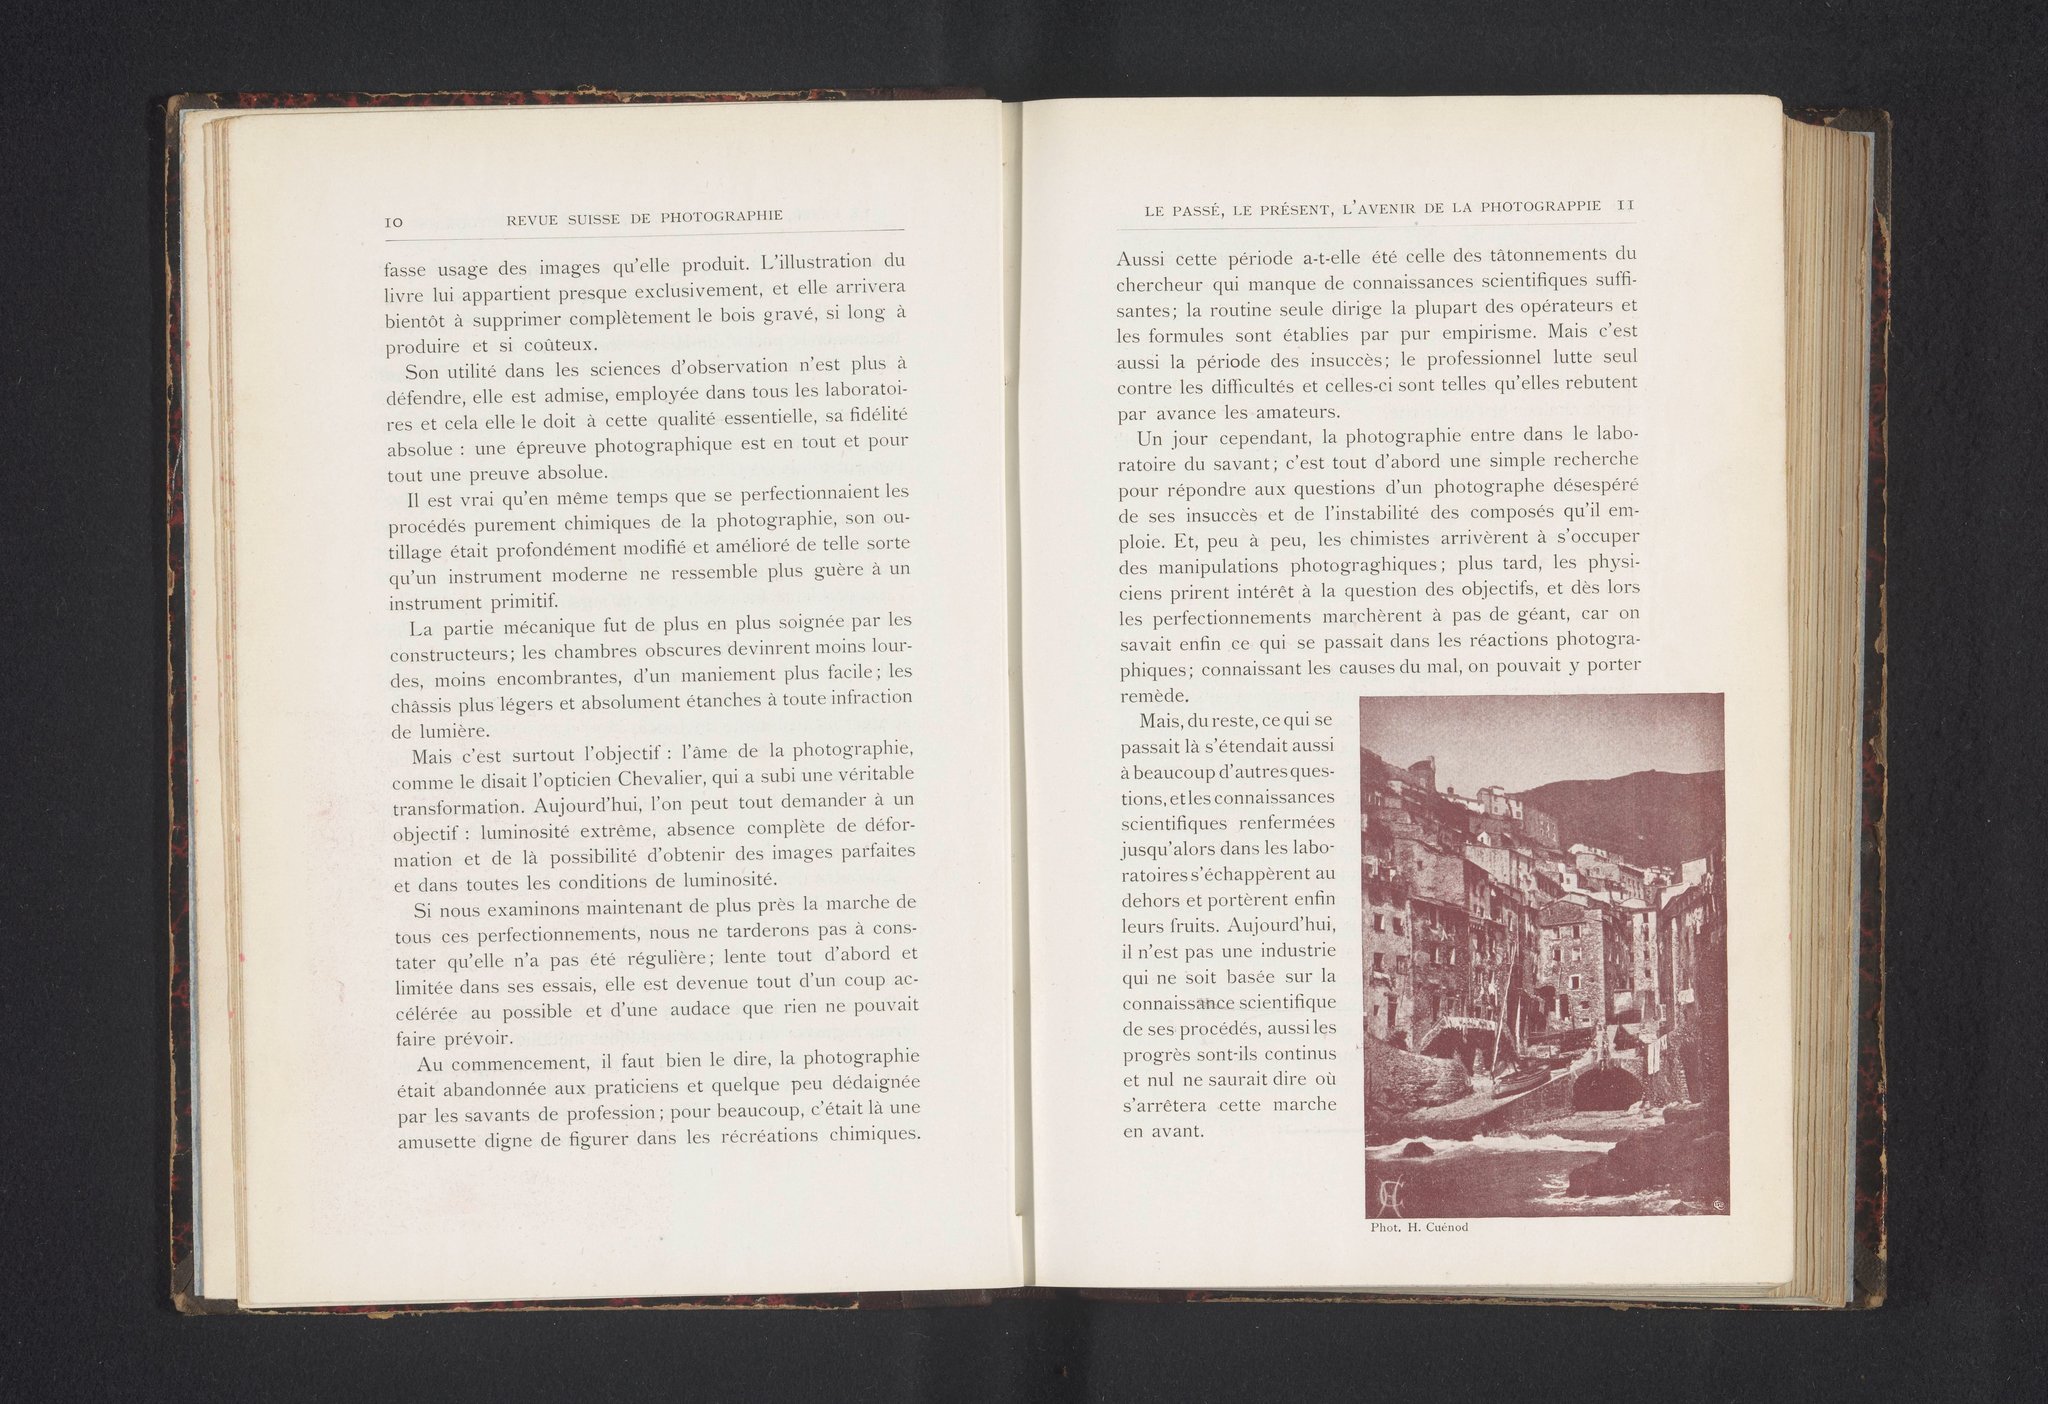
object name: page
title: Stadsgezicht aan de kust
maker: h. cuénod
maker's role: fotograaf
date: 1897-1902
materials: paper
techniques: autotype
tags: city-view in general; 'veduta'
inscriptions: monogram: ‘C. Cie’